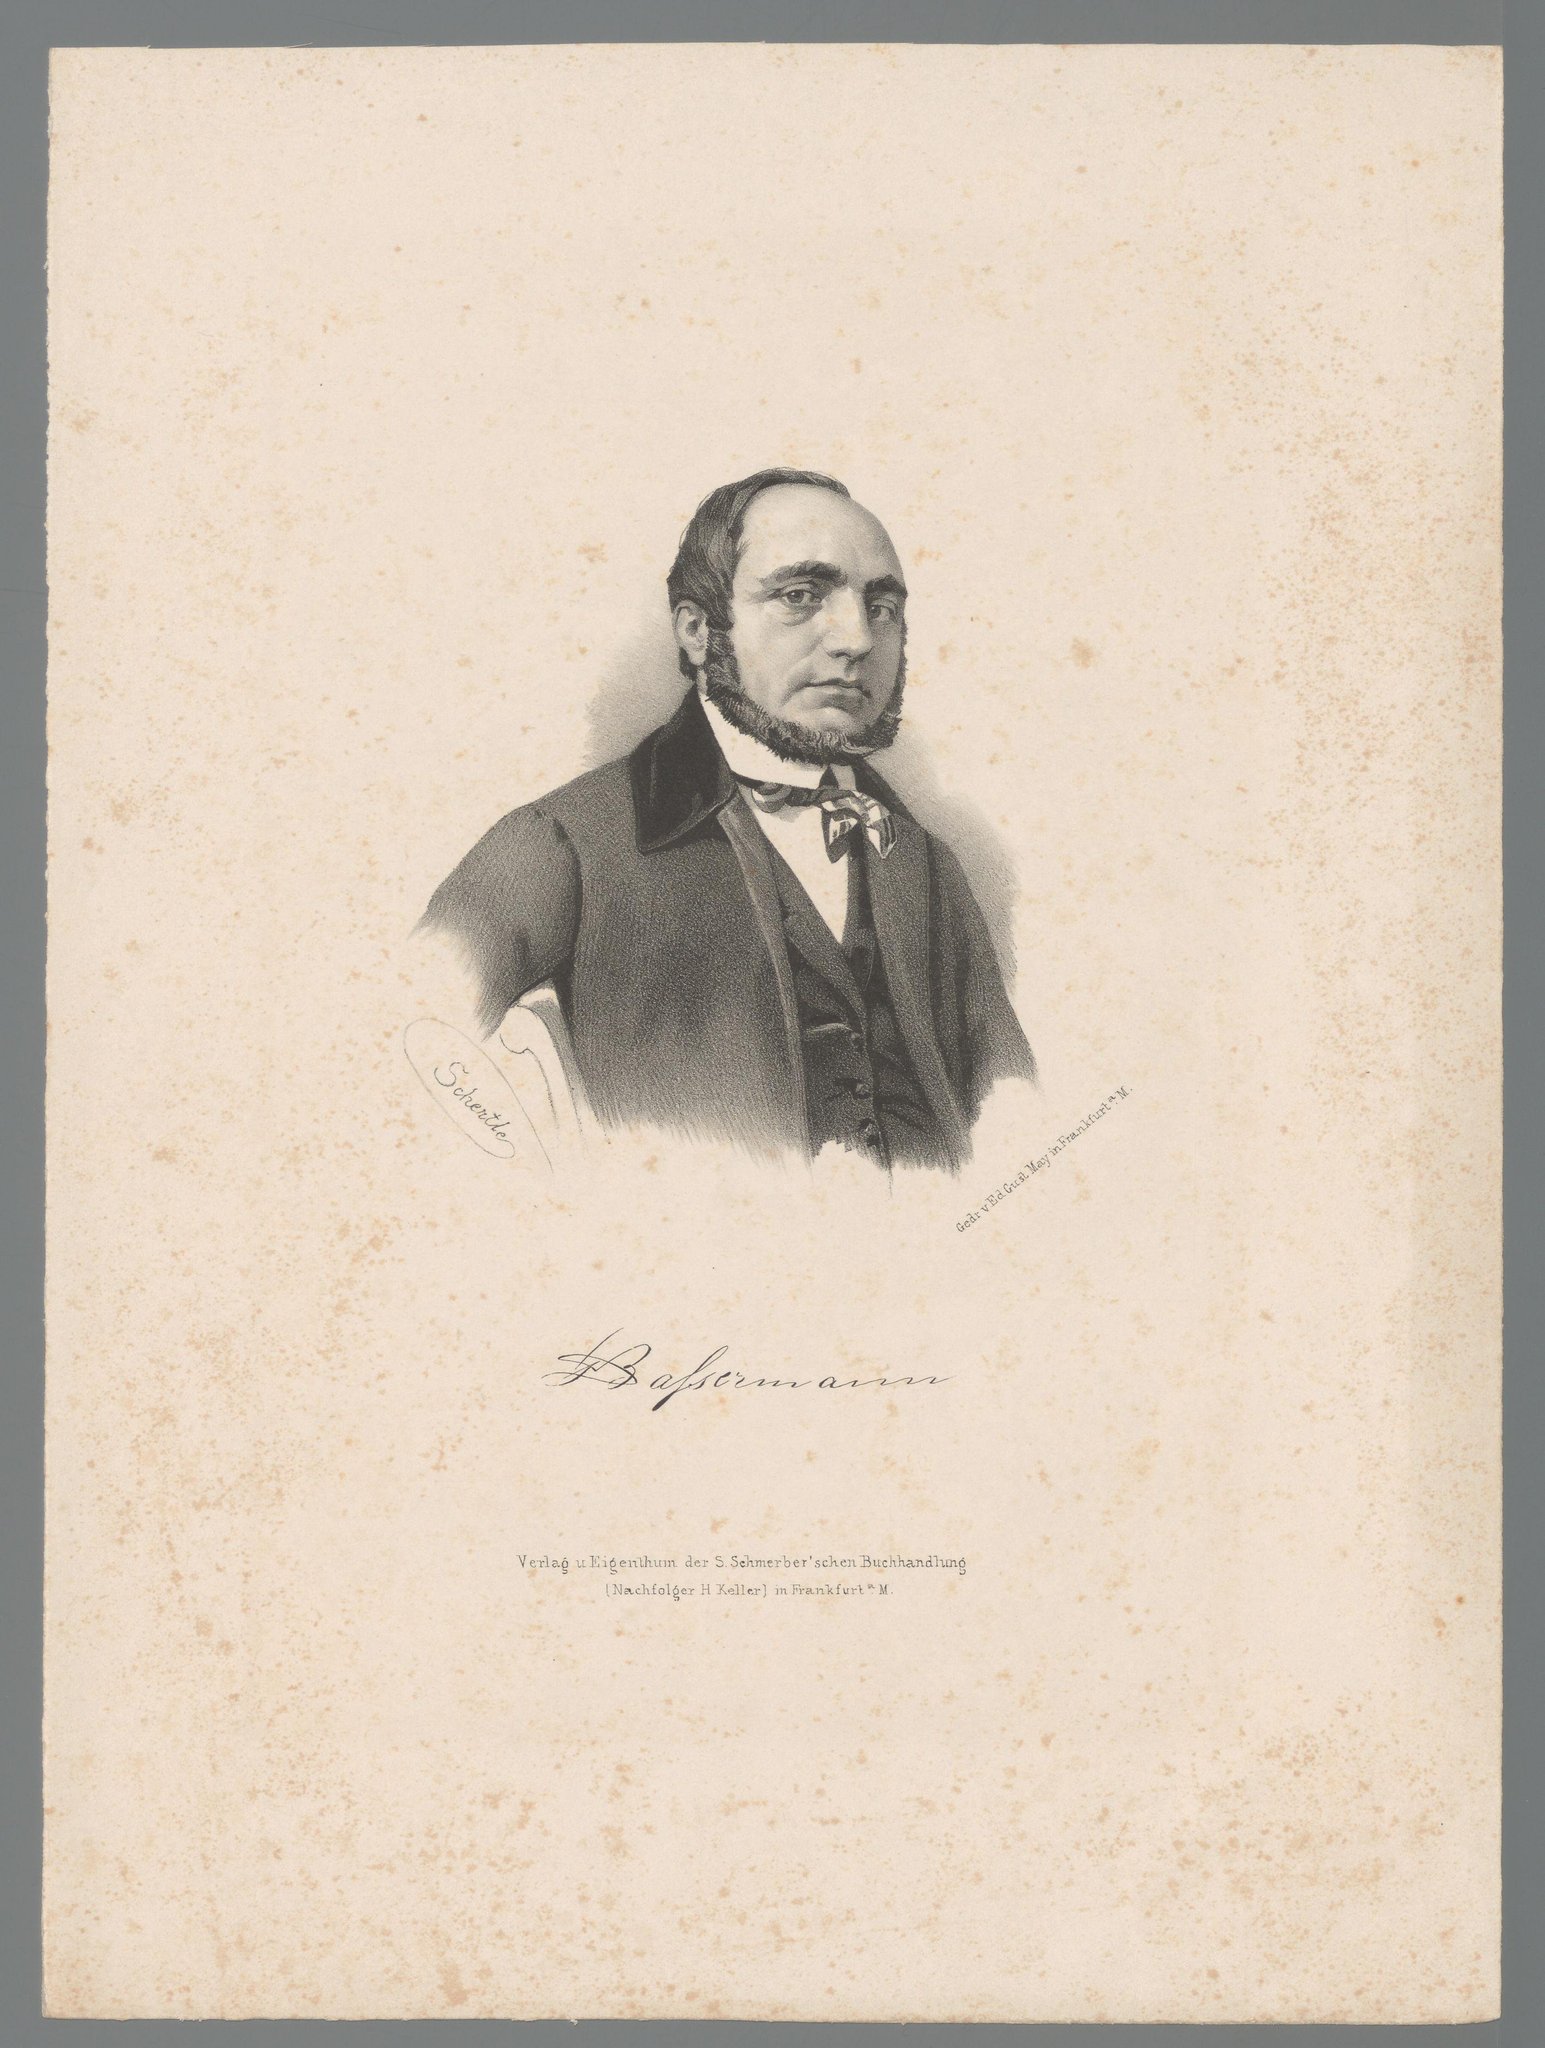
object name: print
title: Die Männer des deutschen Volks, besonders nach Biows Lichtbildern auf Stein gezeichnet von Schertle und Hickmann, oder Deutsche National-Gallerie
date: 1848-1849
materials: paper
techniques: lithograph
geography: frankfurt am main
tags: adult man, historical persons, beard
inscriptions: collector's mark: Lugt 2228